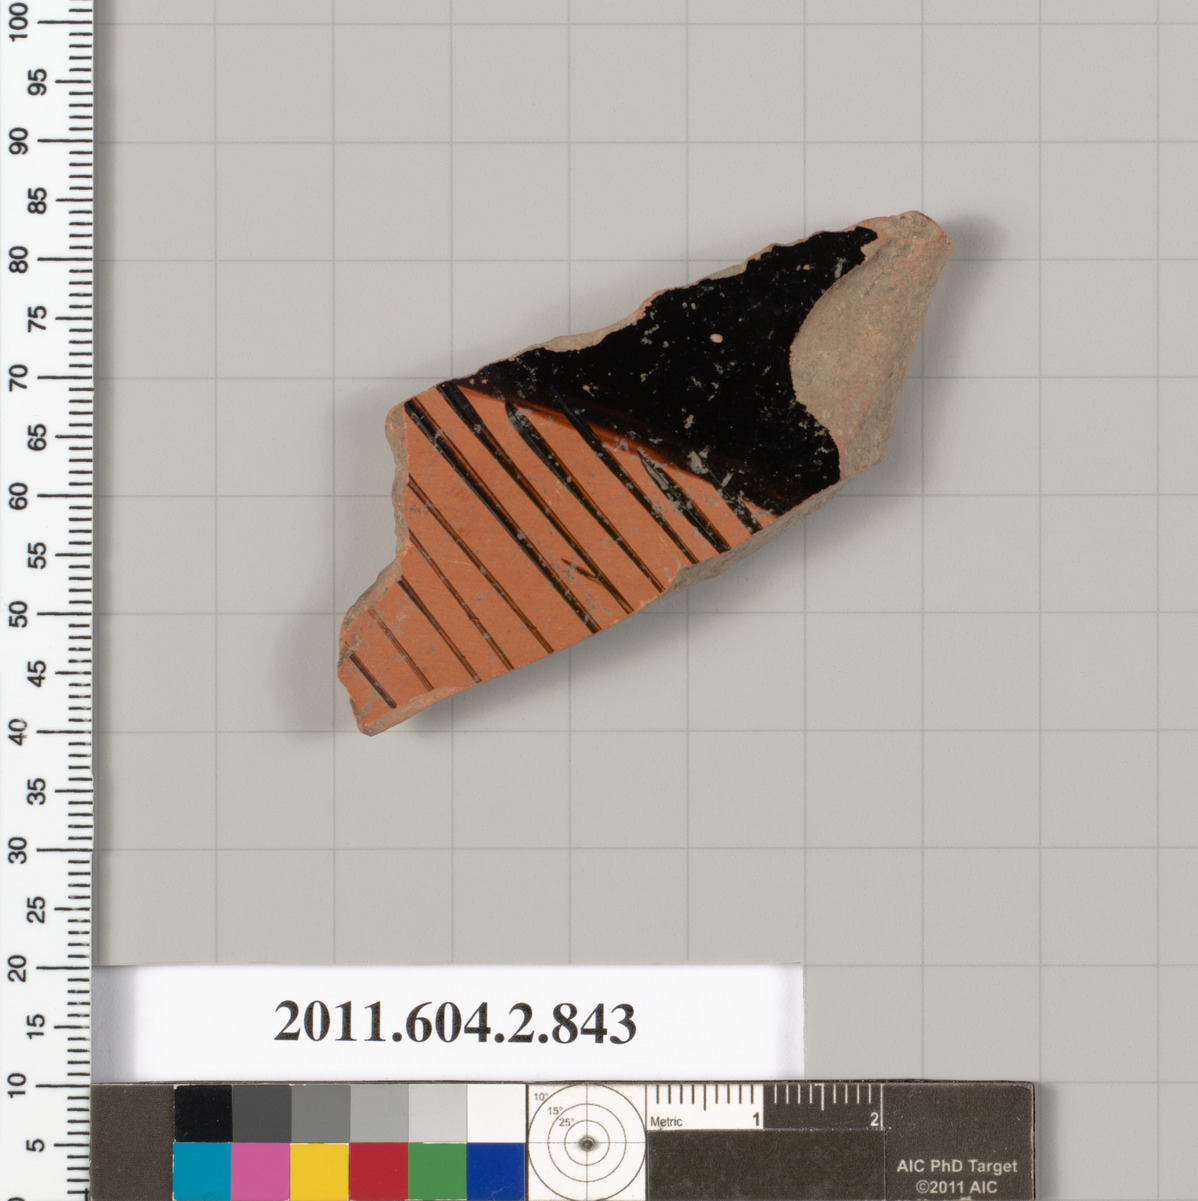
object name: bell krater fragment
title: Terracotta fragment of a bell-krater (bowl for mixing wine and water)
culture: greek, attic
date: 460-450 BCE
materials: terracotta